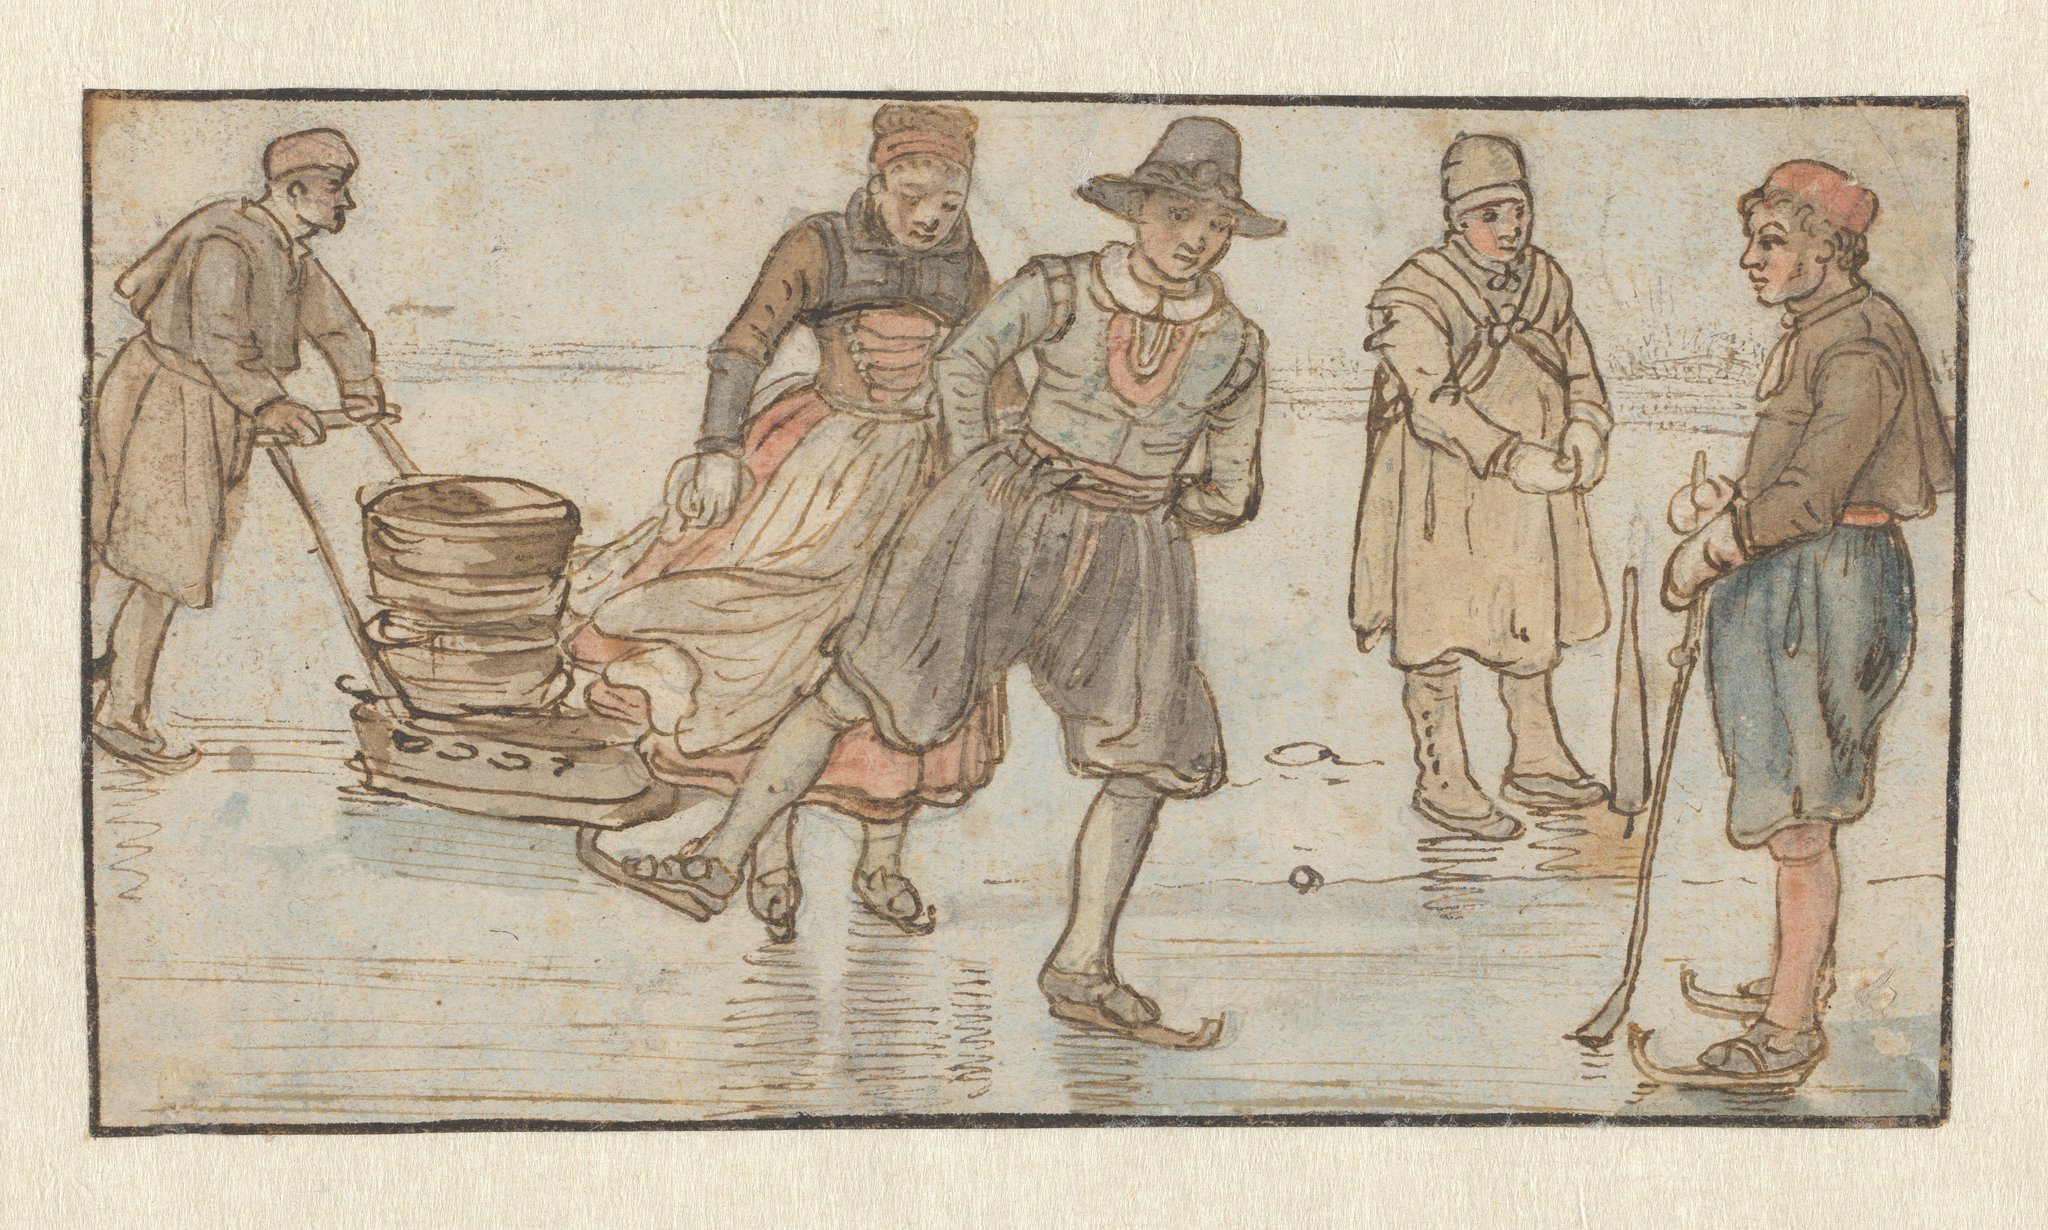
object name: drawing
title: Skaters on the Ice, a Man Pushing a Sledge and a Kolf-player / verso: Two Skaters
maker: hendrick avercamp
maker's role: draughtsman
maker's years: 1585-1634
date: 1620-1625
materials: chalk, graphite, ink, paper, watercolor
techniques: brush, pen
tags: clothes, costume (+ women's clothes), clothes, costume (+ men's clothes), skates (winter sports), 'kolf' on the ice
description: Schaatsers op het ijs; links een man die een slede voortduwt, rechts een kolfspeler.